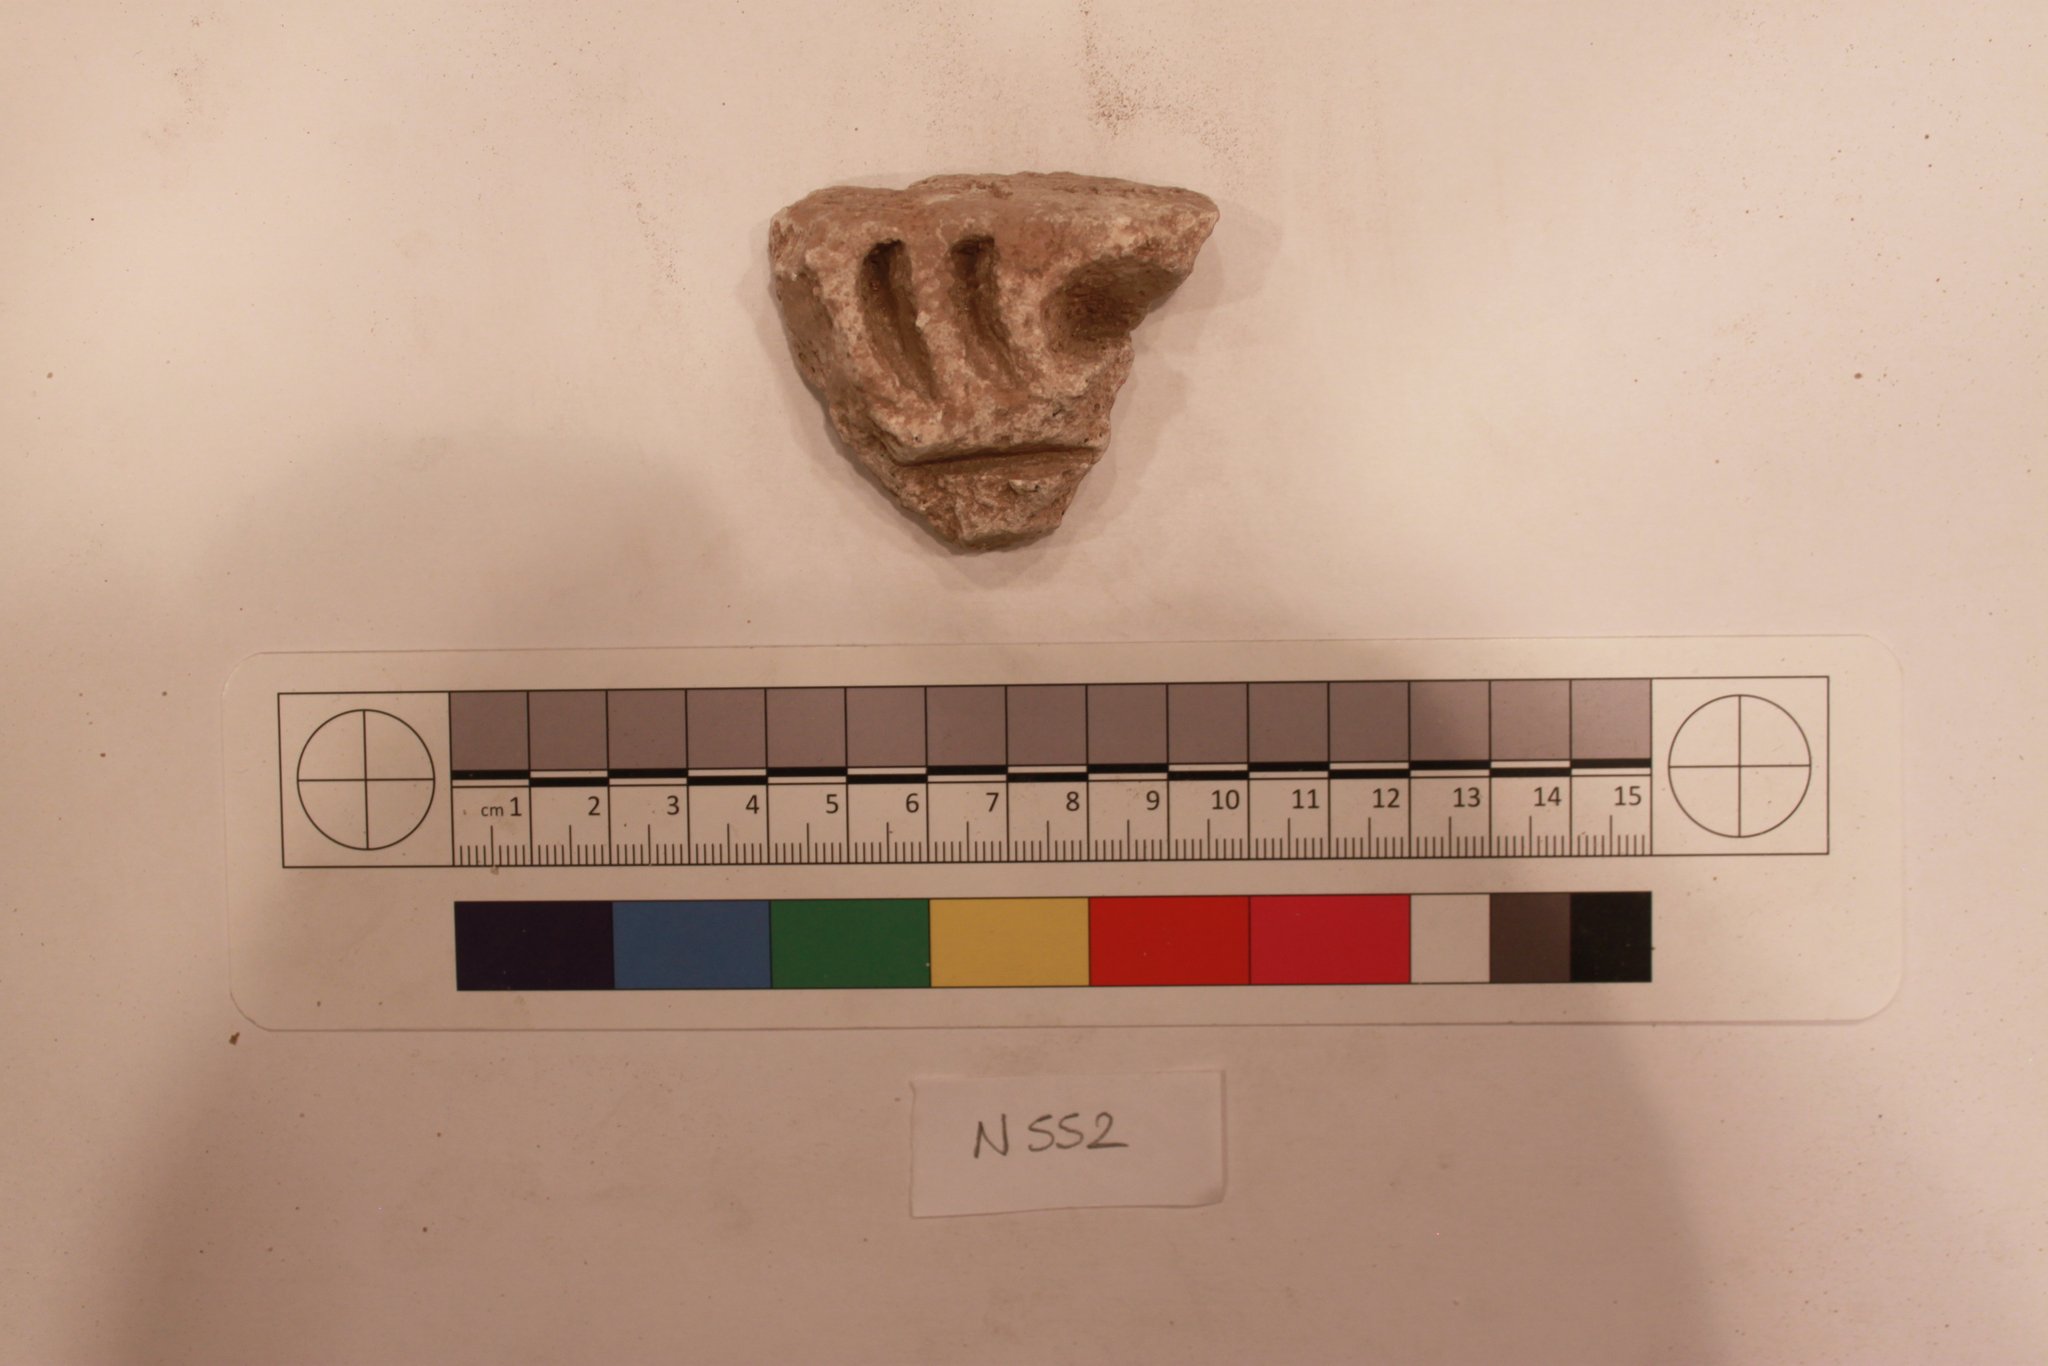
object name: fragment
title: Stucco Fragment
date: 701-1200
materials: plaster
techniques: carving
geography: iran